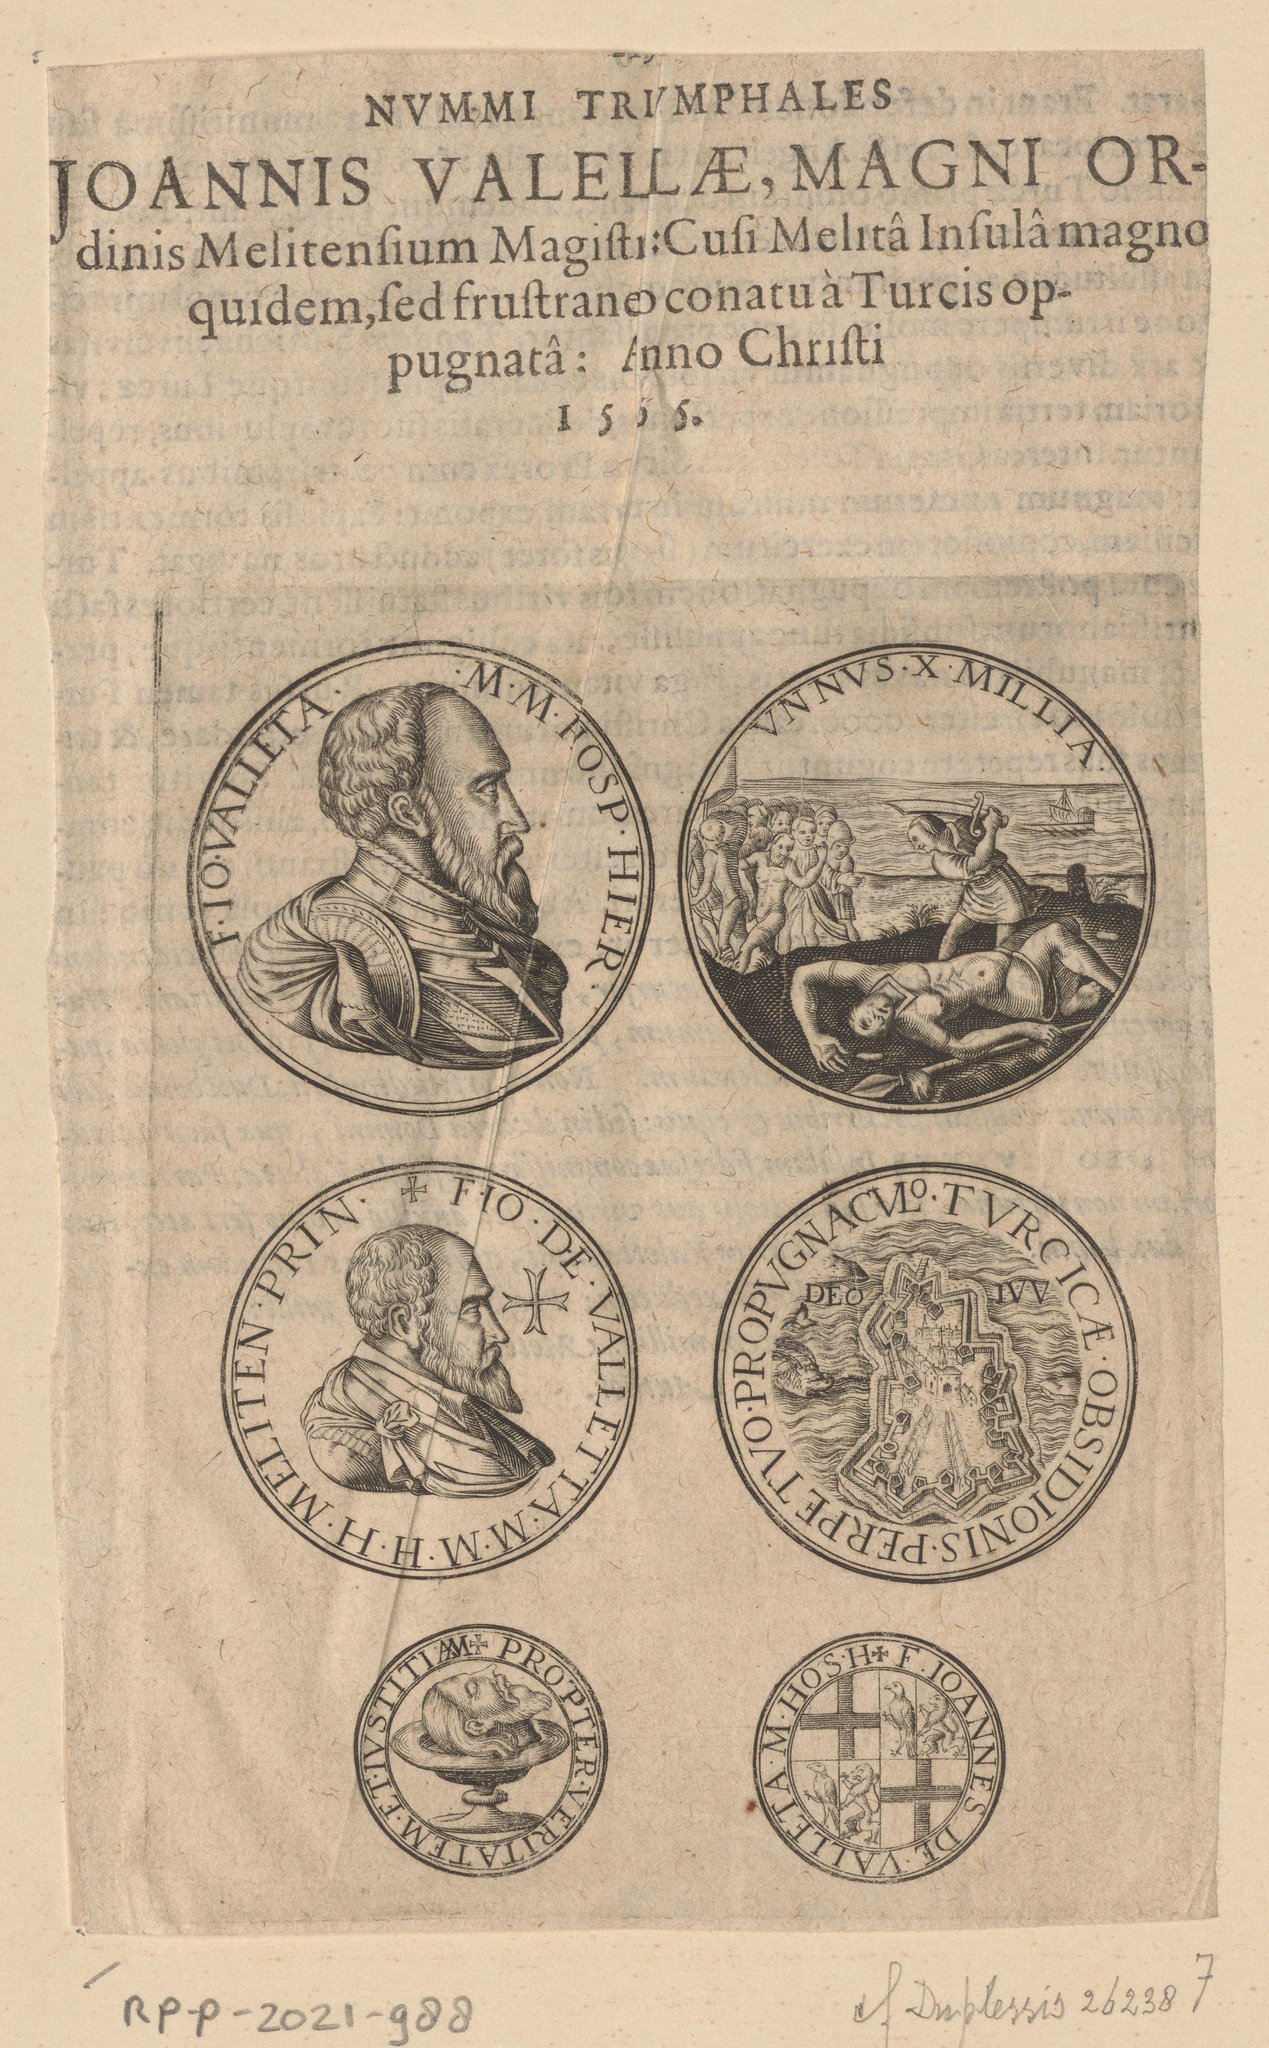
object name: book illustration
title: Voor- en achterzijde van drie munten, waarvan twee met het portret van Jean de La Valette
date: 1620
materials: paper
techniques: engraving, letterpress printing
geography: straatsburg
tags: violent death by sword, maps, atlases, armour, historical persons, memorial medal, head of a beheaded person, siege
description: Op de bovenste munt een portret van La Valette en op de achterzijde wordt iemand aangevallen met een zwaard, vermoedelijk tijdens het Beleg van Malta (1565). Op de munt daaronder wederom een portret van La Valette en een kaart van Malta. Daaronder een munt met een hoofd op een schaal en het wapen van La Valette.